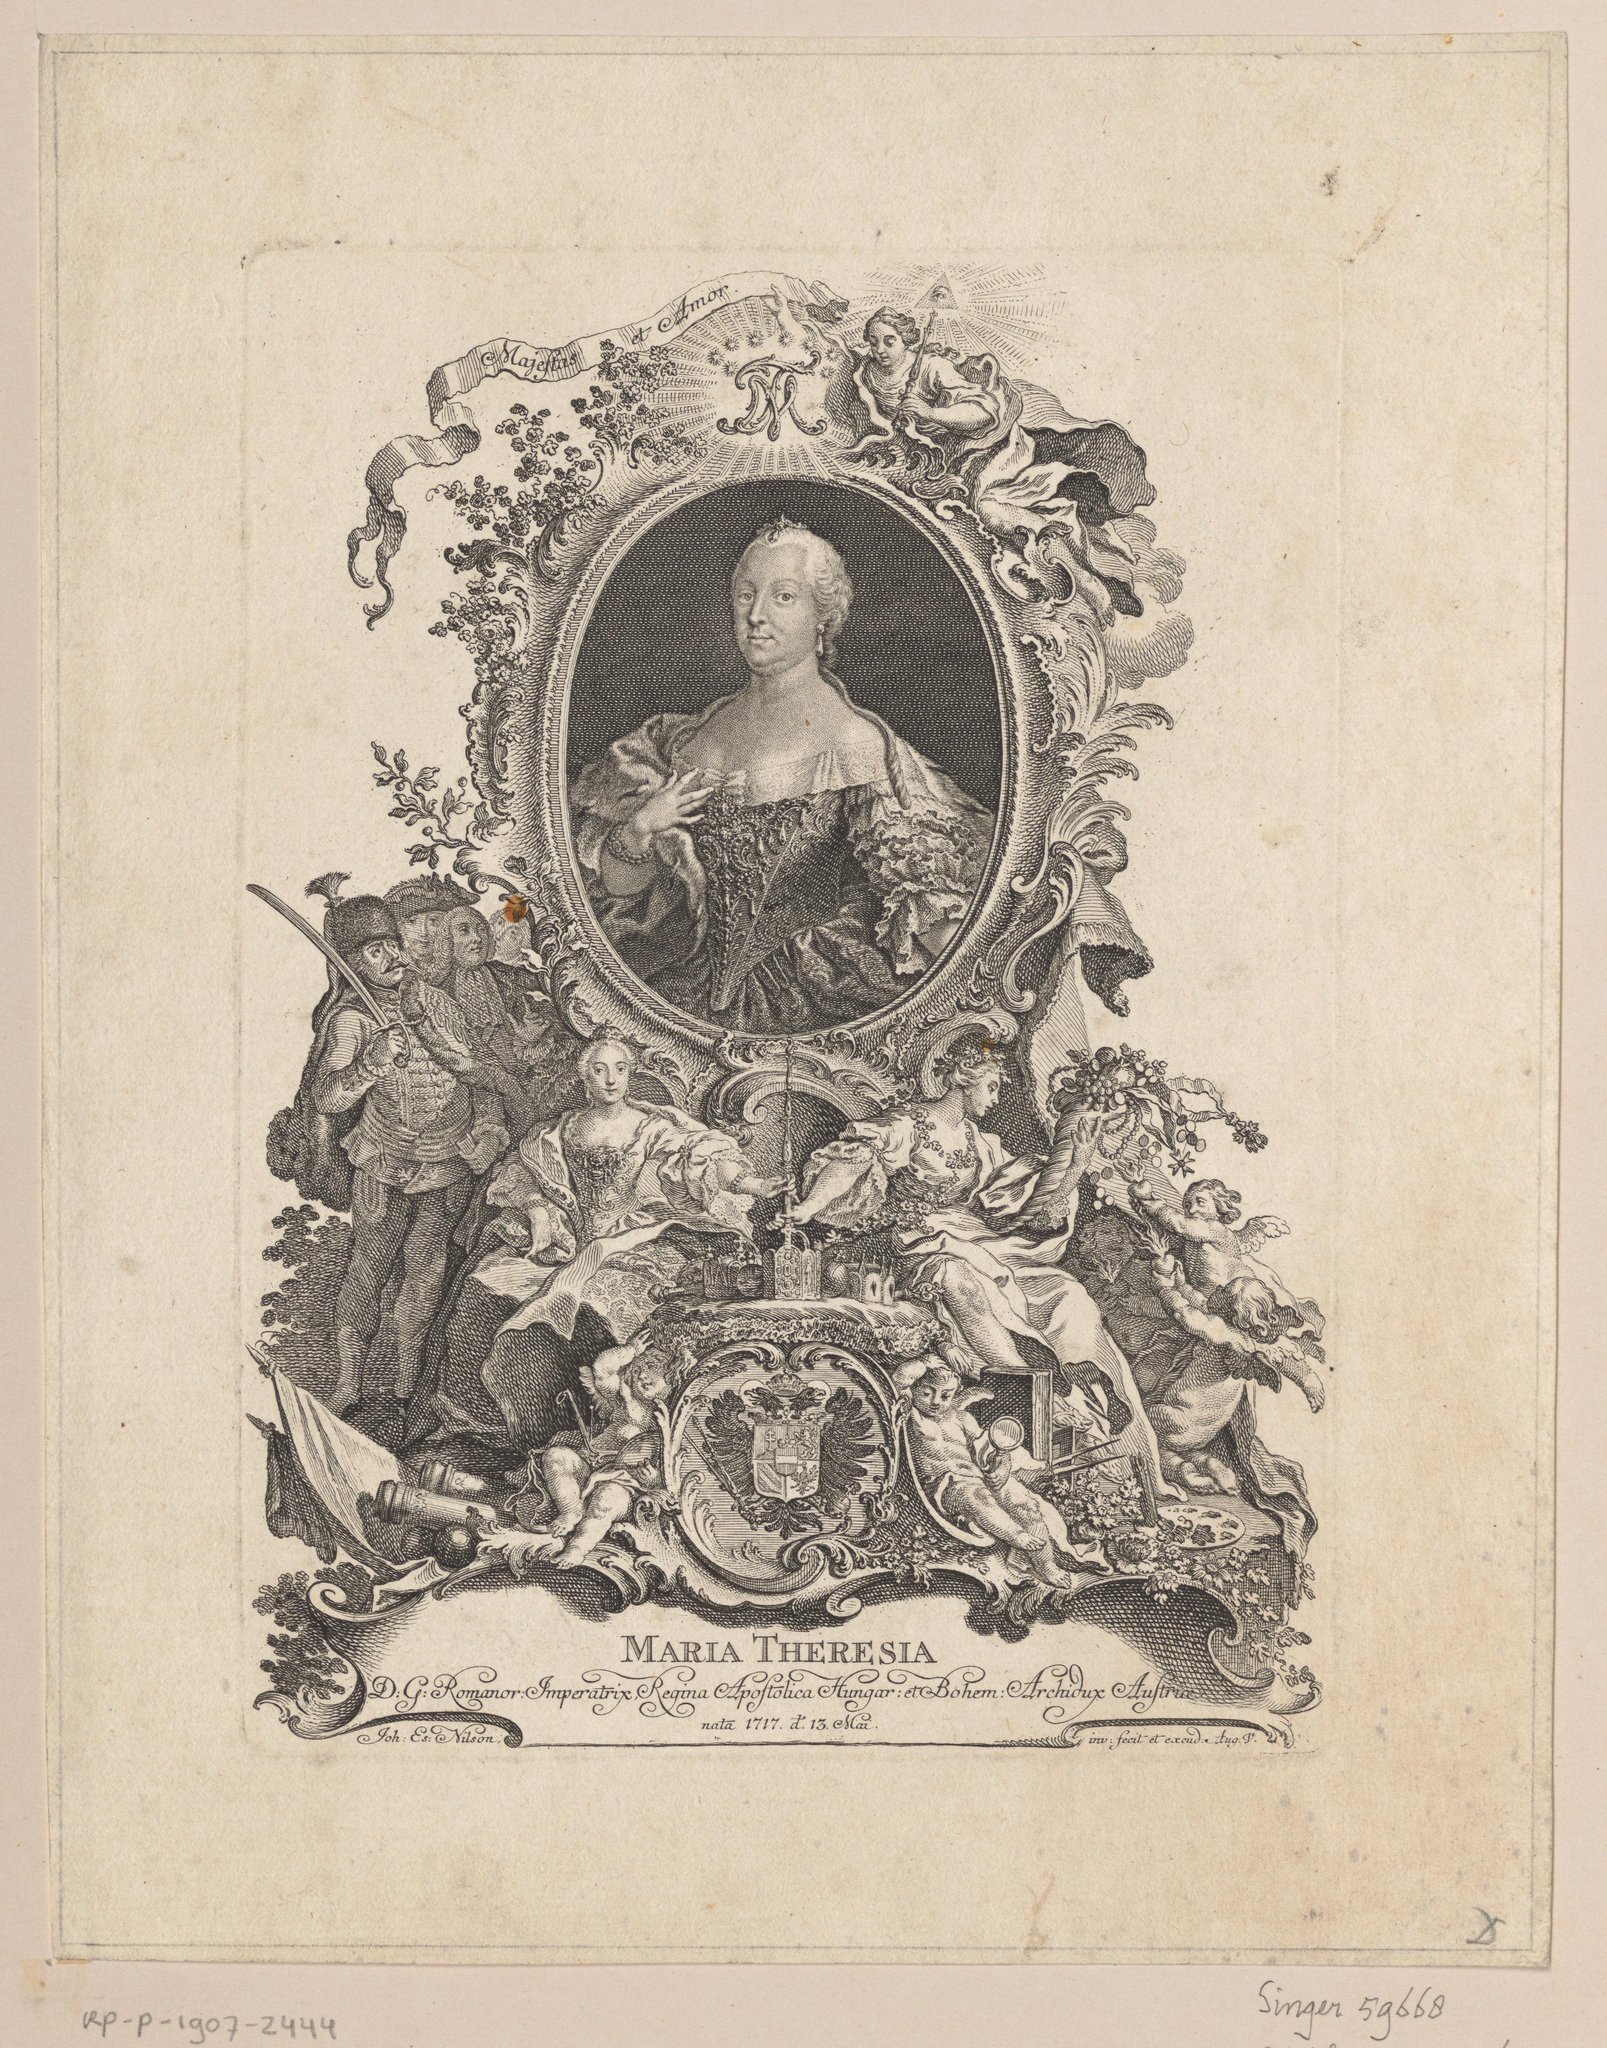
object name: ornament print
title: Portret van Maria Theresia van Oostenrijk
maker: johann esaias nilson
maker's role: draughtsman, print maker, publisher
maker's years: 1721-1788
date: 1745-1780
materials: paper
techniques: engraving, etching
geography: augsburg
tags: maria theresia (koningin van frankrijk), rocaille ornament, historical persons - bb - woman, ornament ~ medallion, cupids: 'amores', 'amoretti', 'putti', emperor - bb - female ruler, armorial bearing, heraldry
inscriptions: collector's mark: Lugt 2228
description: Portret van Maria Theresia van Oostenrijk in rocaille omlijsting. Aan de bovenzijde een vrouw met een scepter met het alziend oog en een banier met tekst Majestas et Amor. Onder de omlijsting een wapenschild met tweekoppige adelaar, omringd door twee zittende vrouwen met een scepter en een hoorn des overvloeds. Links staan een Hongaarse soldaat en drie andere figuren. Rechts drie putti met brandende harten.